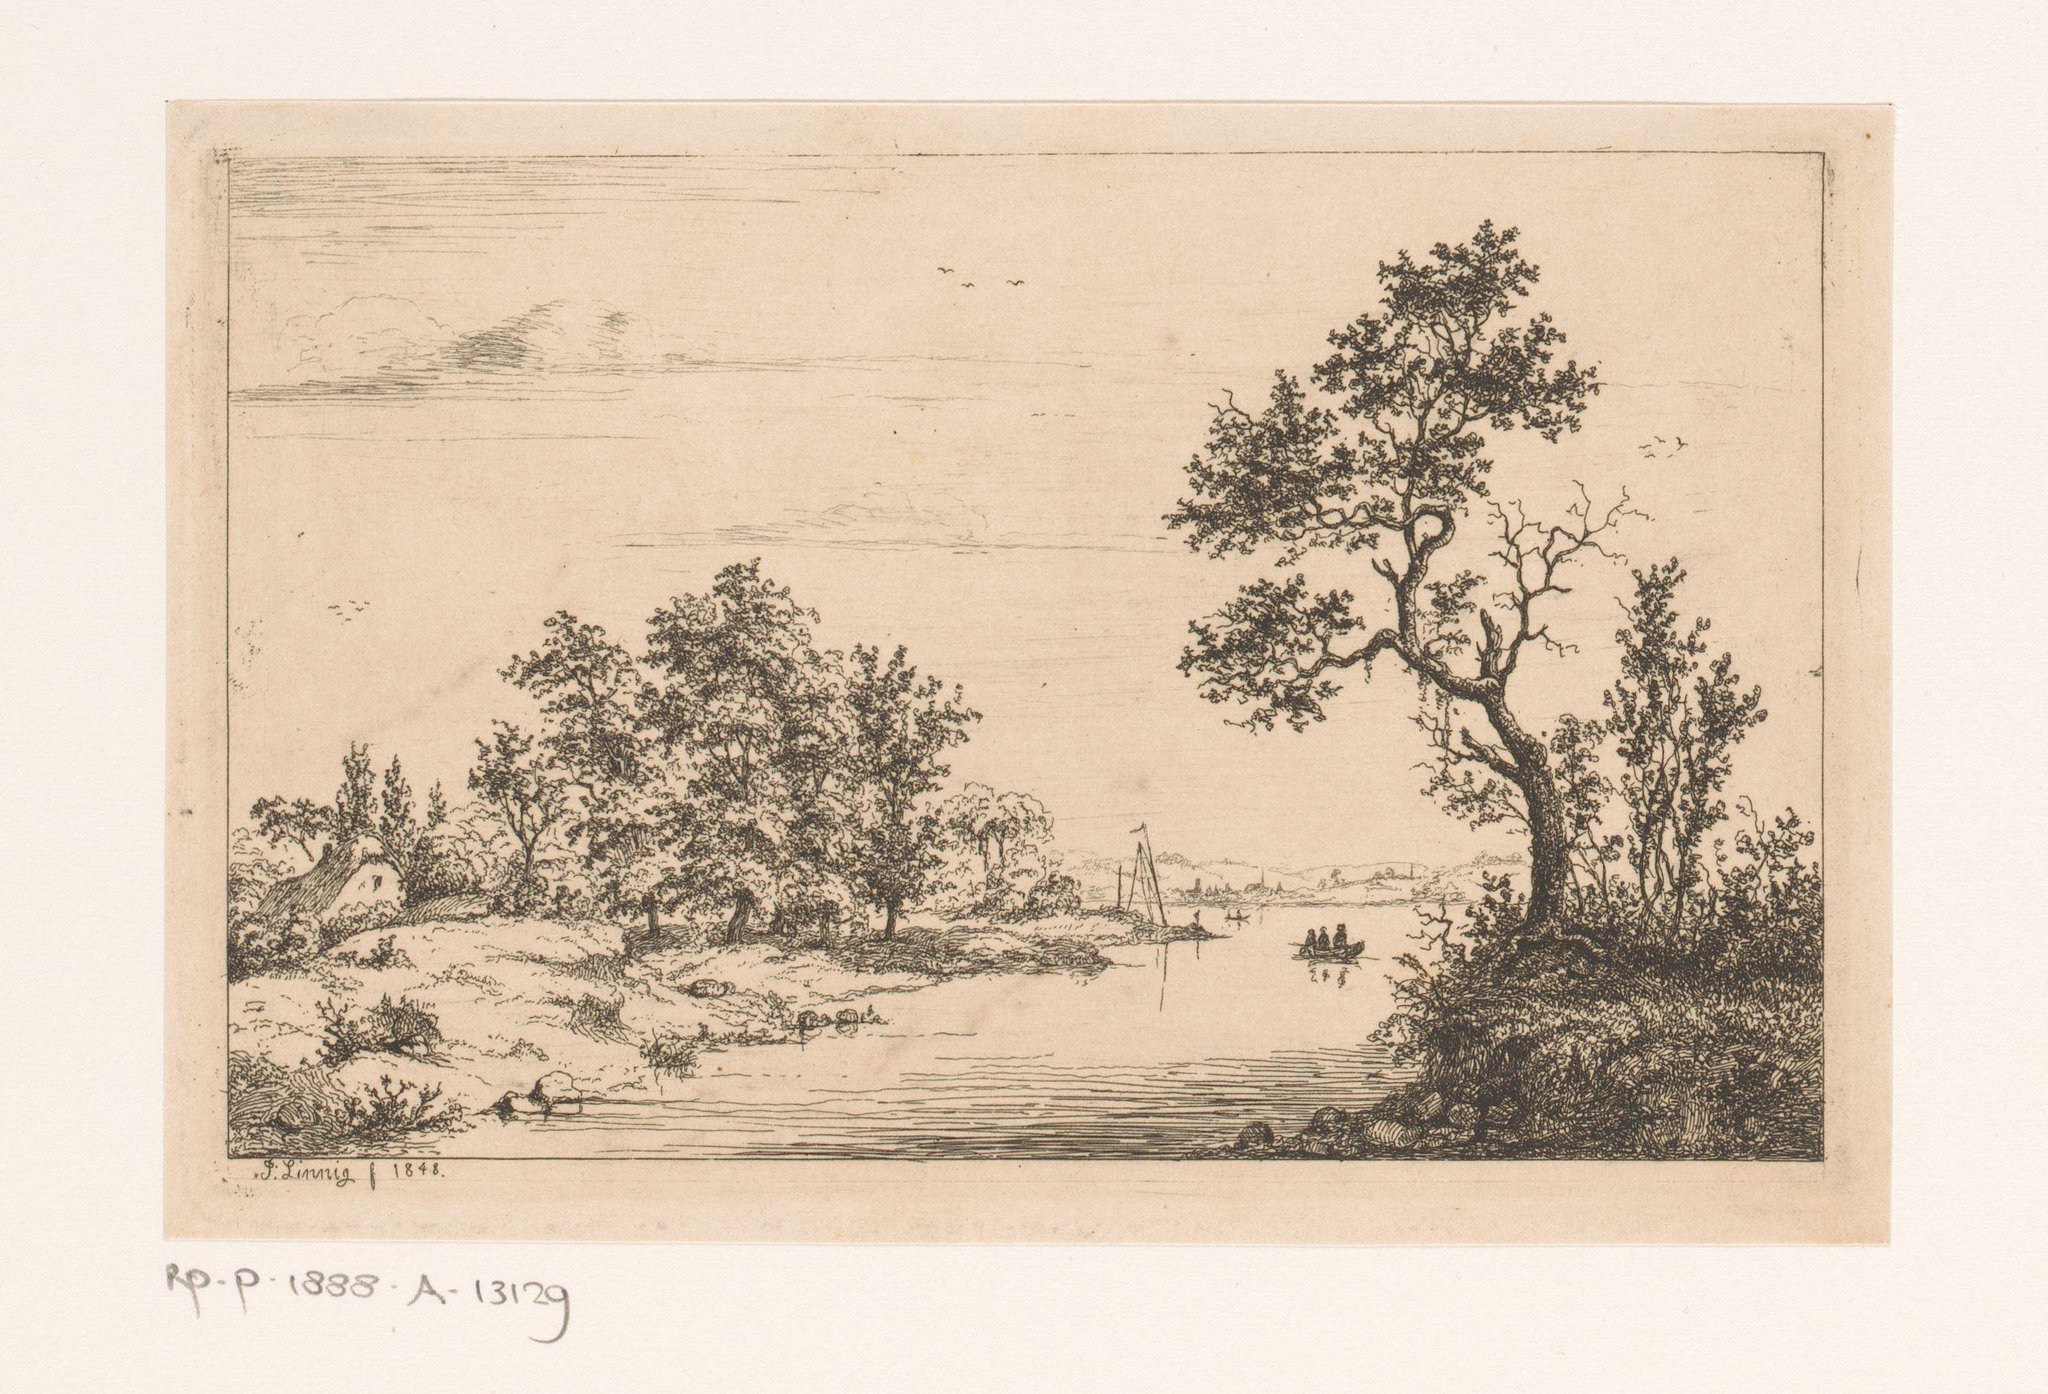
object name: print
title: Riviergezicht bij Düsseldorf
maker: jean théodore joseph linnig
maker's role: draughtsman, print maker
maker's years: 1815-1891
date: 1848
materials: paper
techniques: etching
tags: river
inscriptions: collector's mark: Lugt 2228